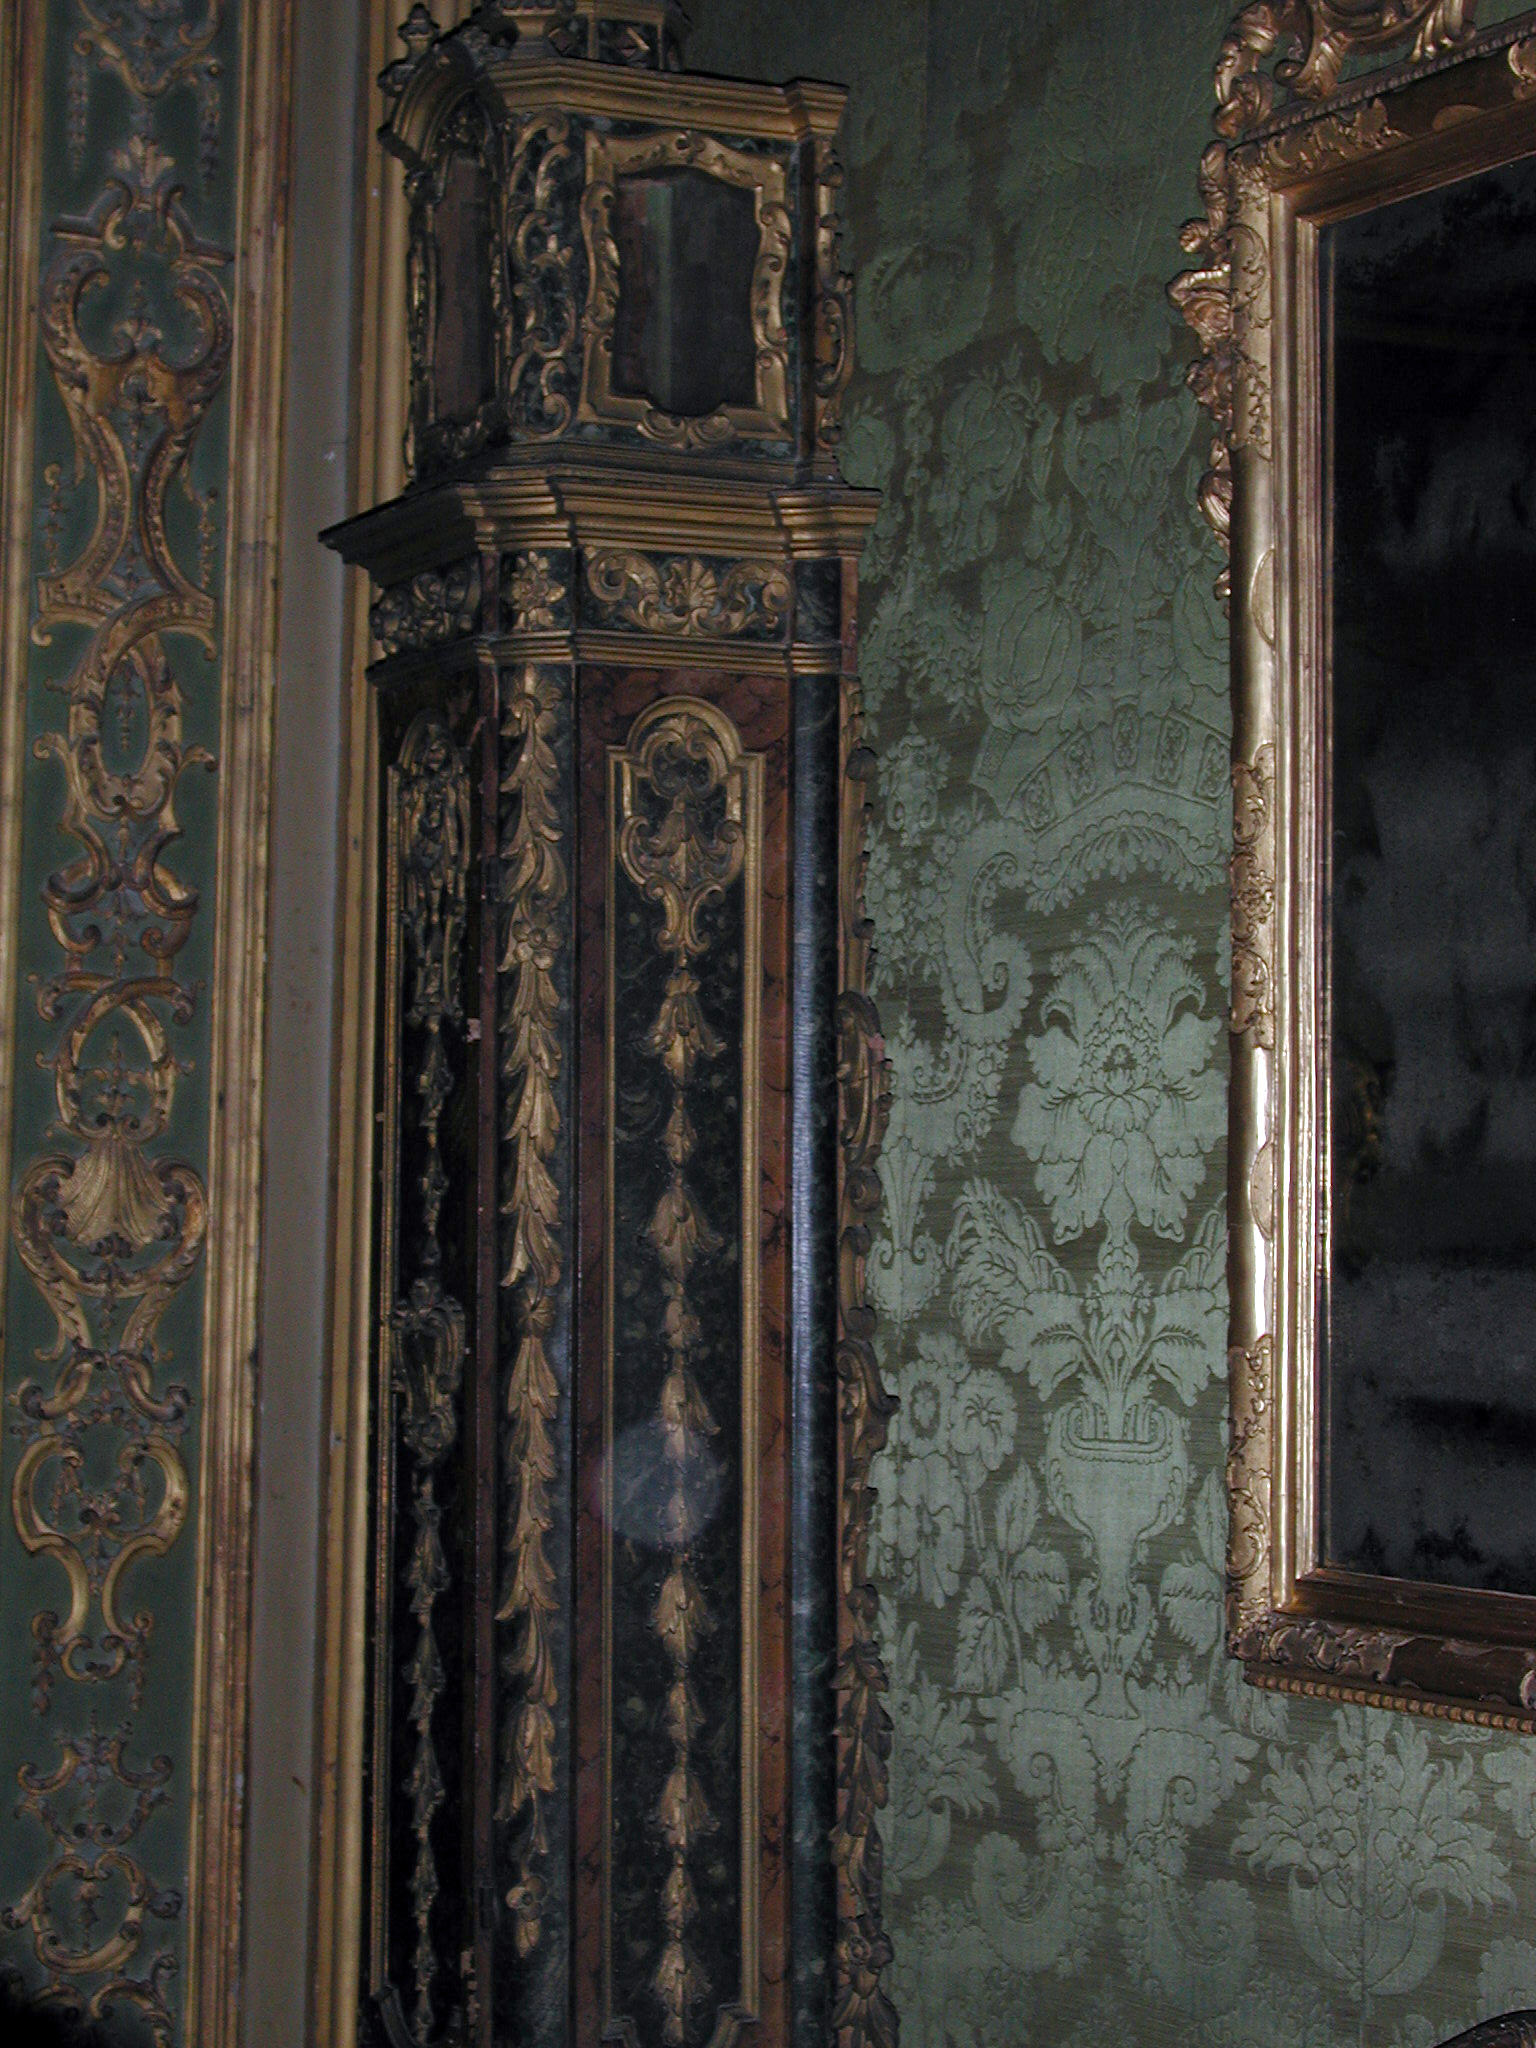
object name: clock case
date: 1601-1700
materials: wood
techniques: gilding, painting